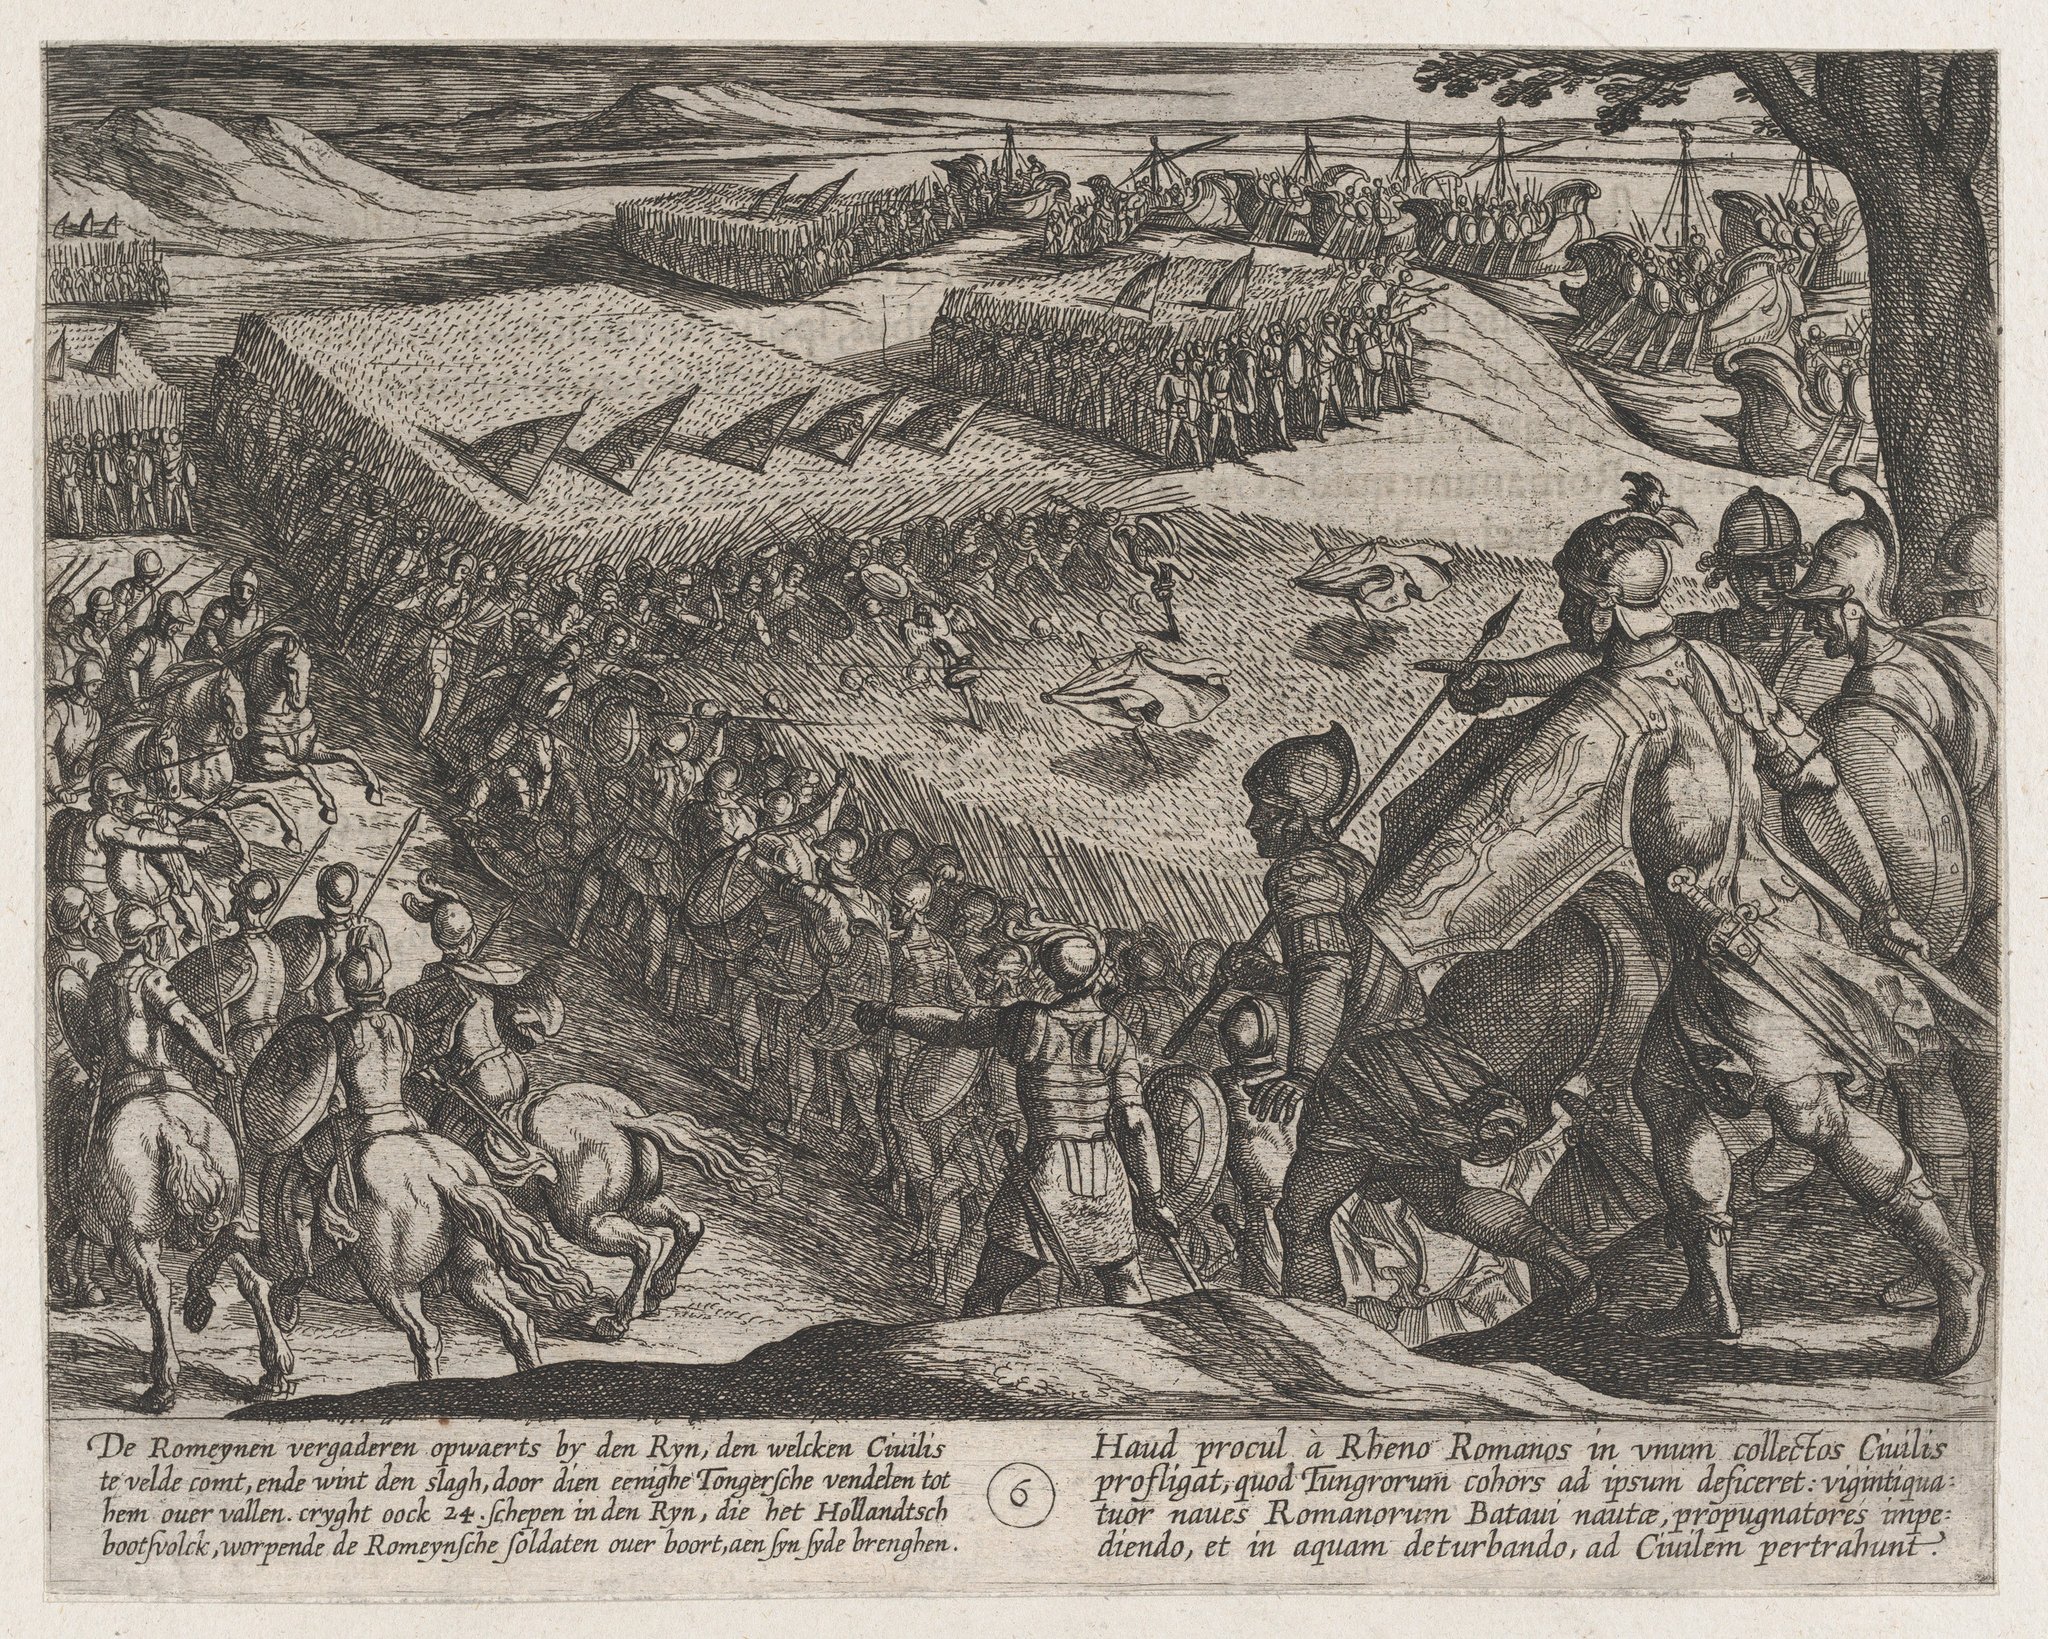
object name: print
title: Plate 6: Romans Defeated Near the Rhine, from The War of the Romans Against the Batavians (Romanorvm et Batavorvm Societas)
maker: antonio tempesta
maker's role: artist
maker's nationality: italian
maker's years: 1555-1630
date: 1611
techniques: etching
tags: battles,soldiers,horses,ships